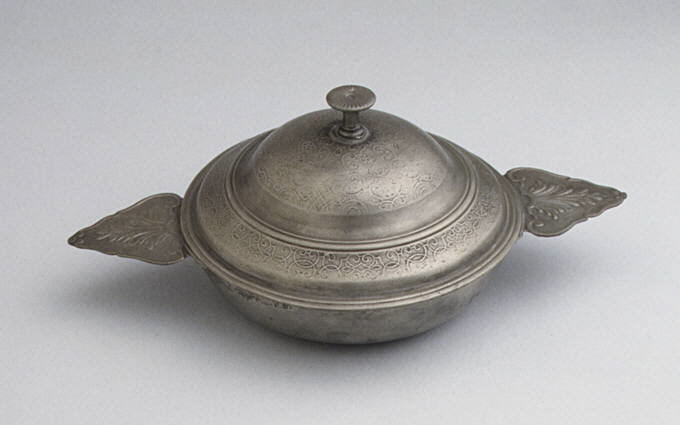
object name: broth bowl with cover écuelle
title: Broth bowl with cover (Écuelle)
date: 1720-1770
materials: pewter